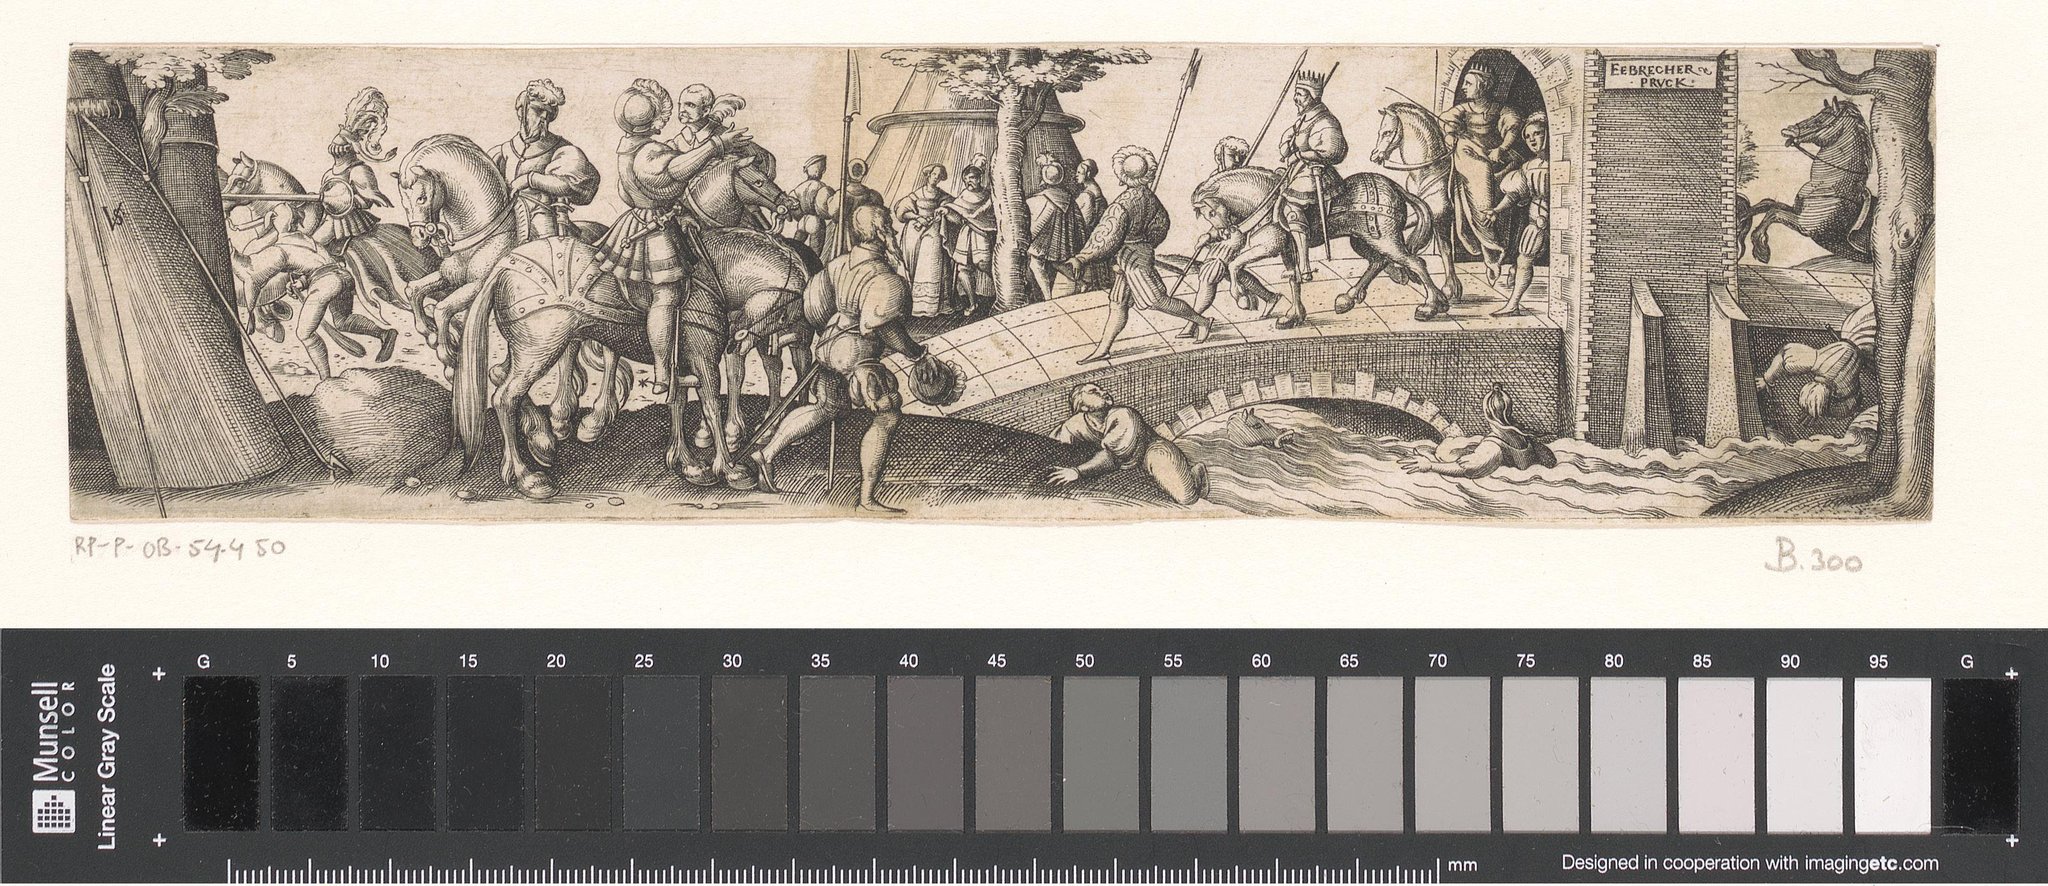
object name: print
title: Brug van het overspel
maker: virgilius solis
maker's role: draughtsman, print maker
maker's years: 1514-1562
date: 1524-1562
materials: paper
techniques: engraving, etching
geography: nuremberg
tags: riding a horse, ass, or mule; rider, horseman, adulterer, cheat, deceit; 'fraude', 'inganno' (ripa), bridge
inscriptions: number: ‘46’, collector's mark: Lugt 2228